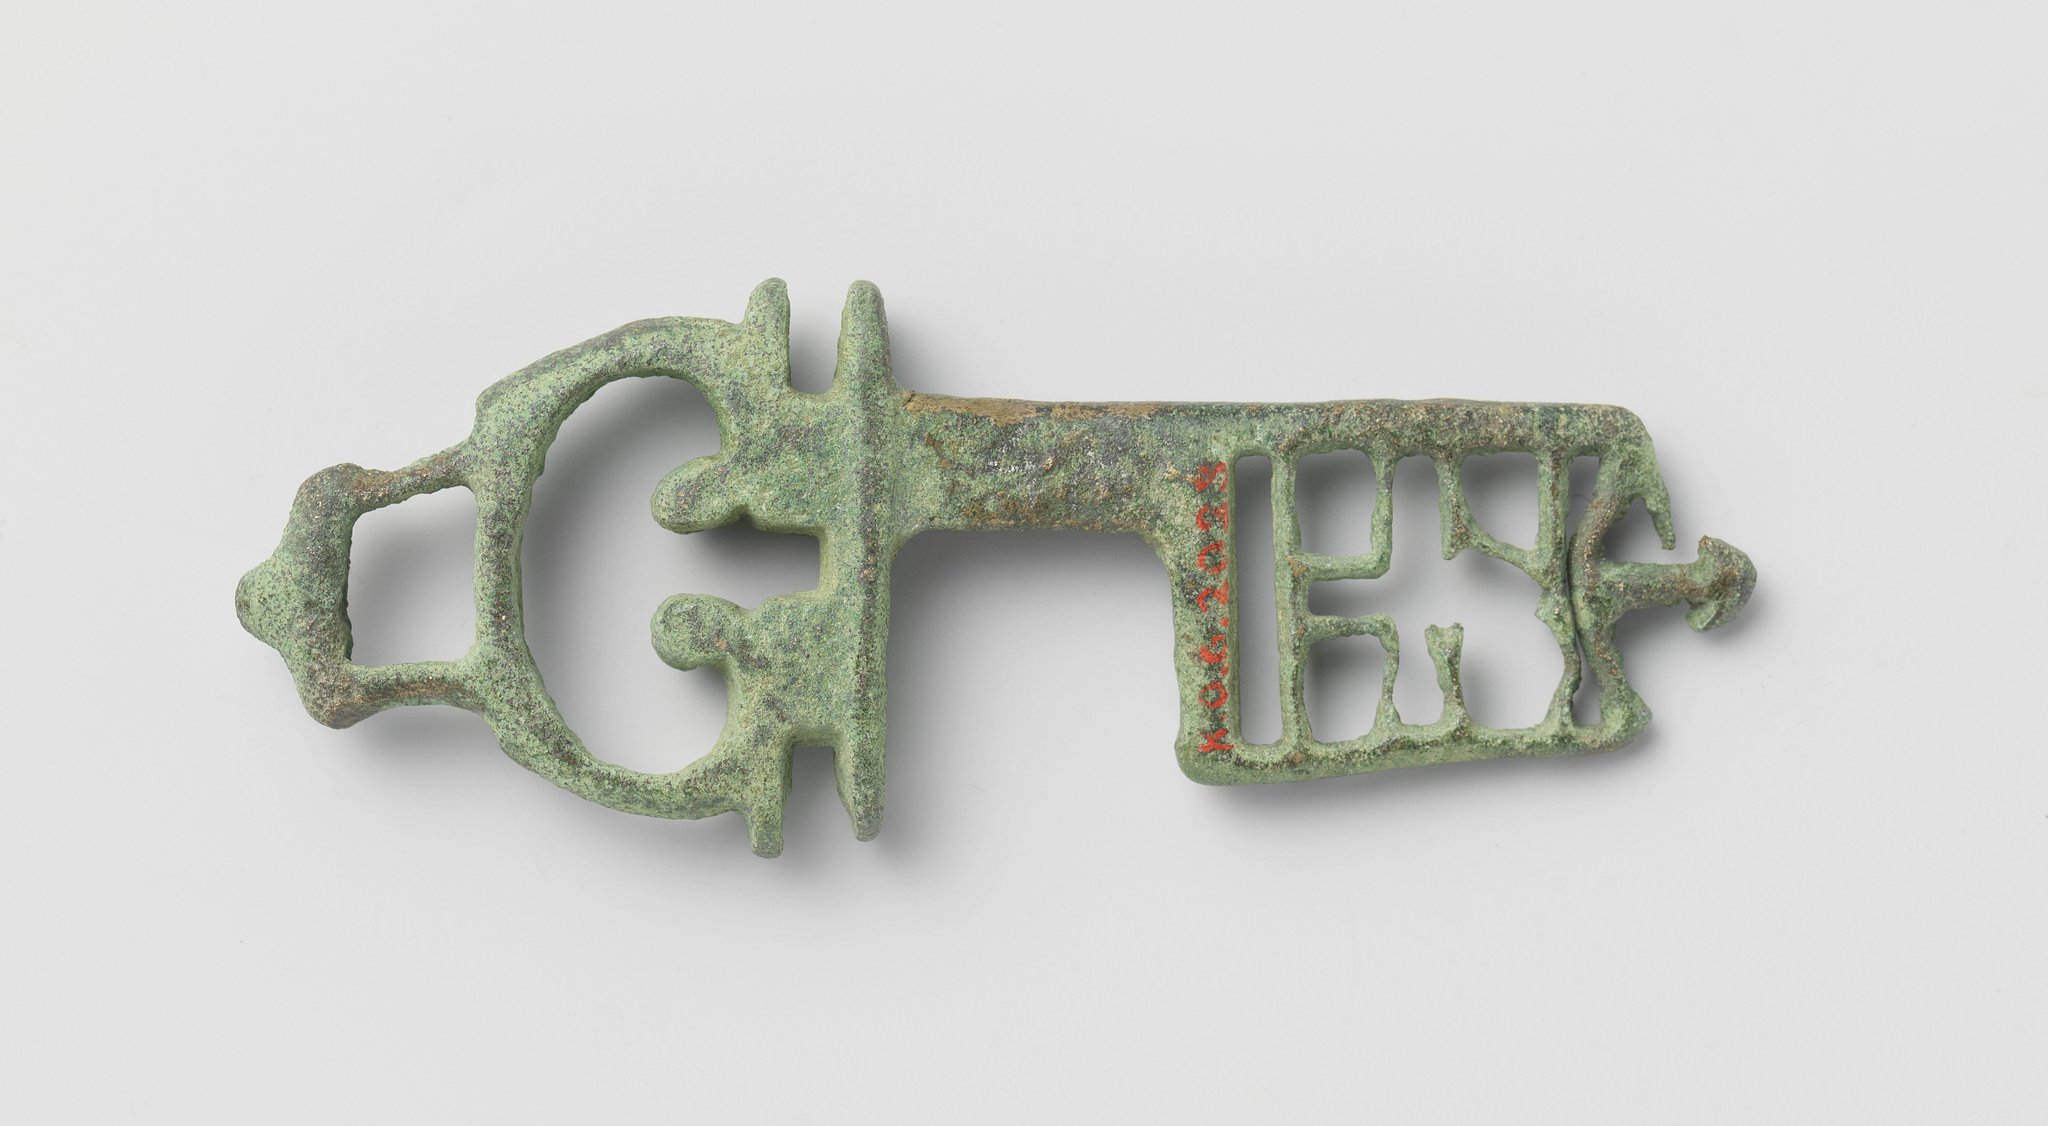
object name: schuifsleutel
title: Key latch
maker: Anonymous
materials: bronze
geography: rome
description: Schuifsleutel met greep bestaande uit een naar beneden gewende C-voluut, waarboven een opstandje, dat voor oog dient. De baard is met een zijverbinding aan de platte sleutelborst bevestigd en eindigt in een pijltje. Baard beschadigd.